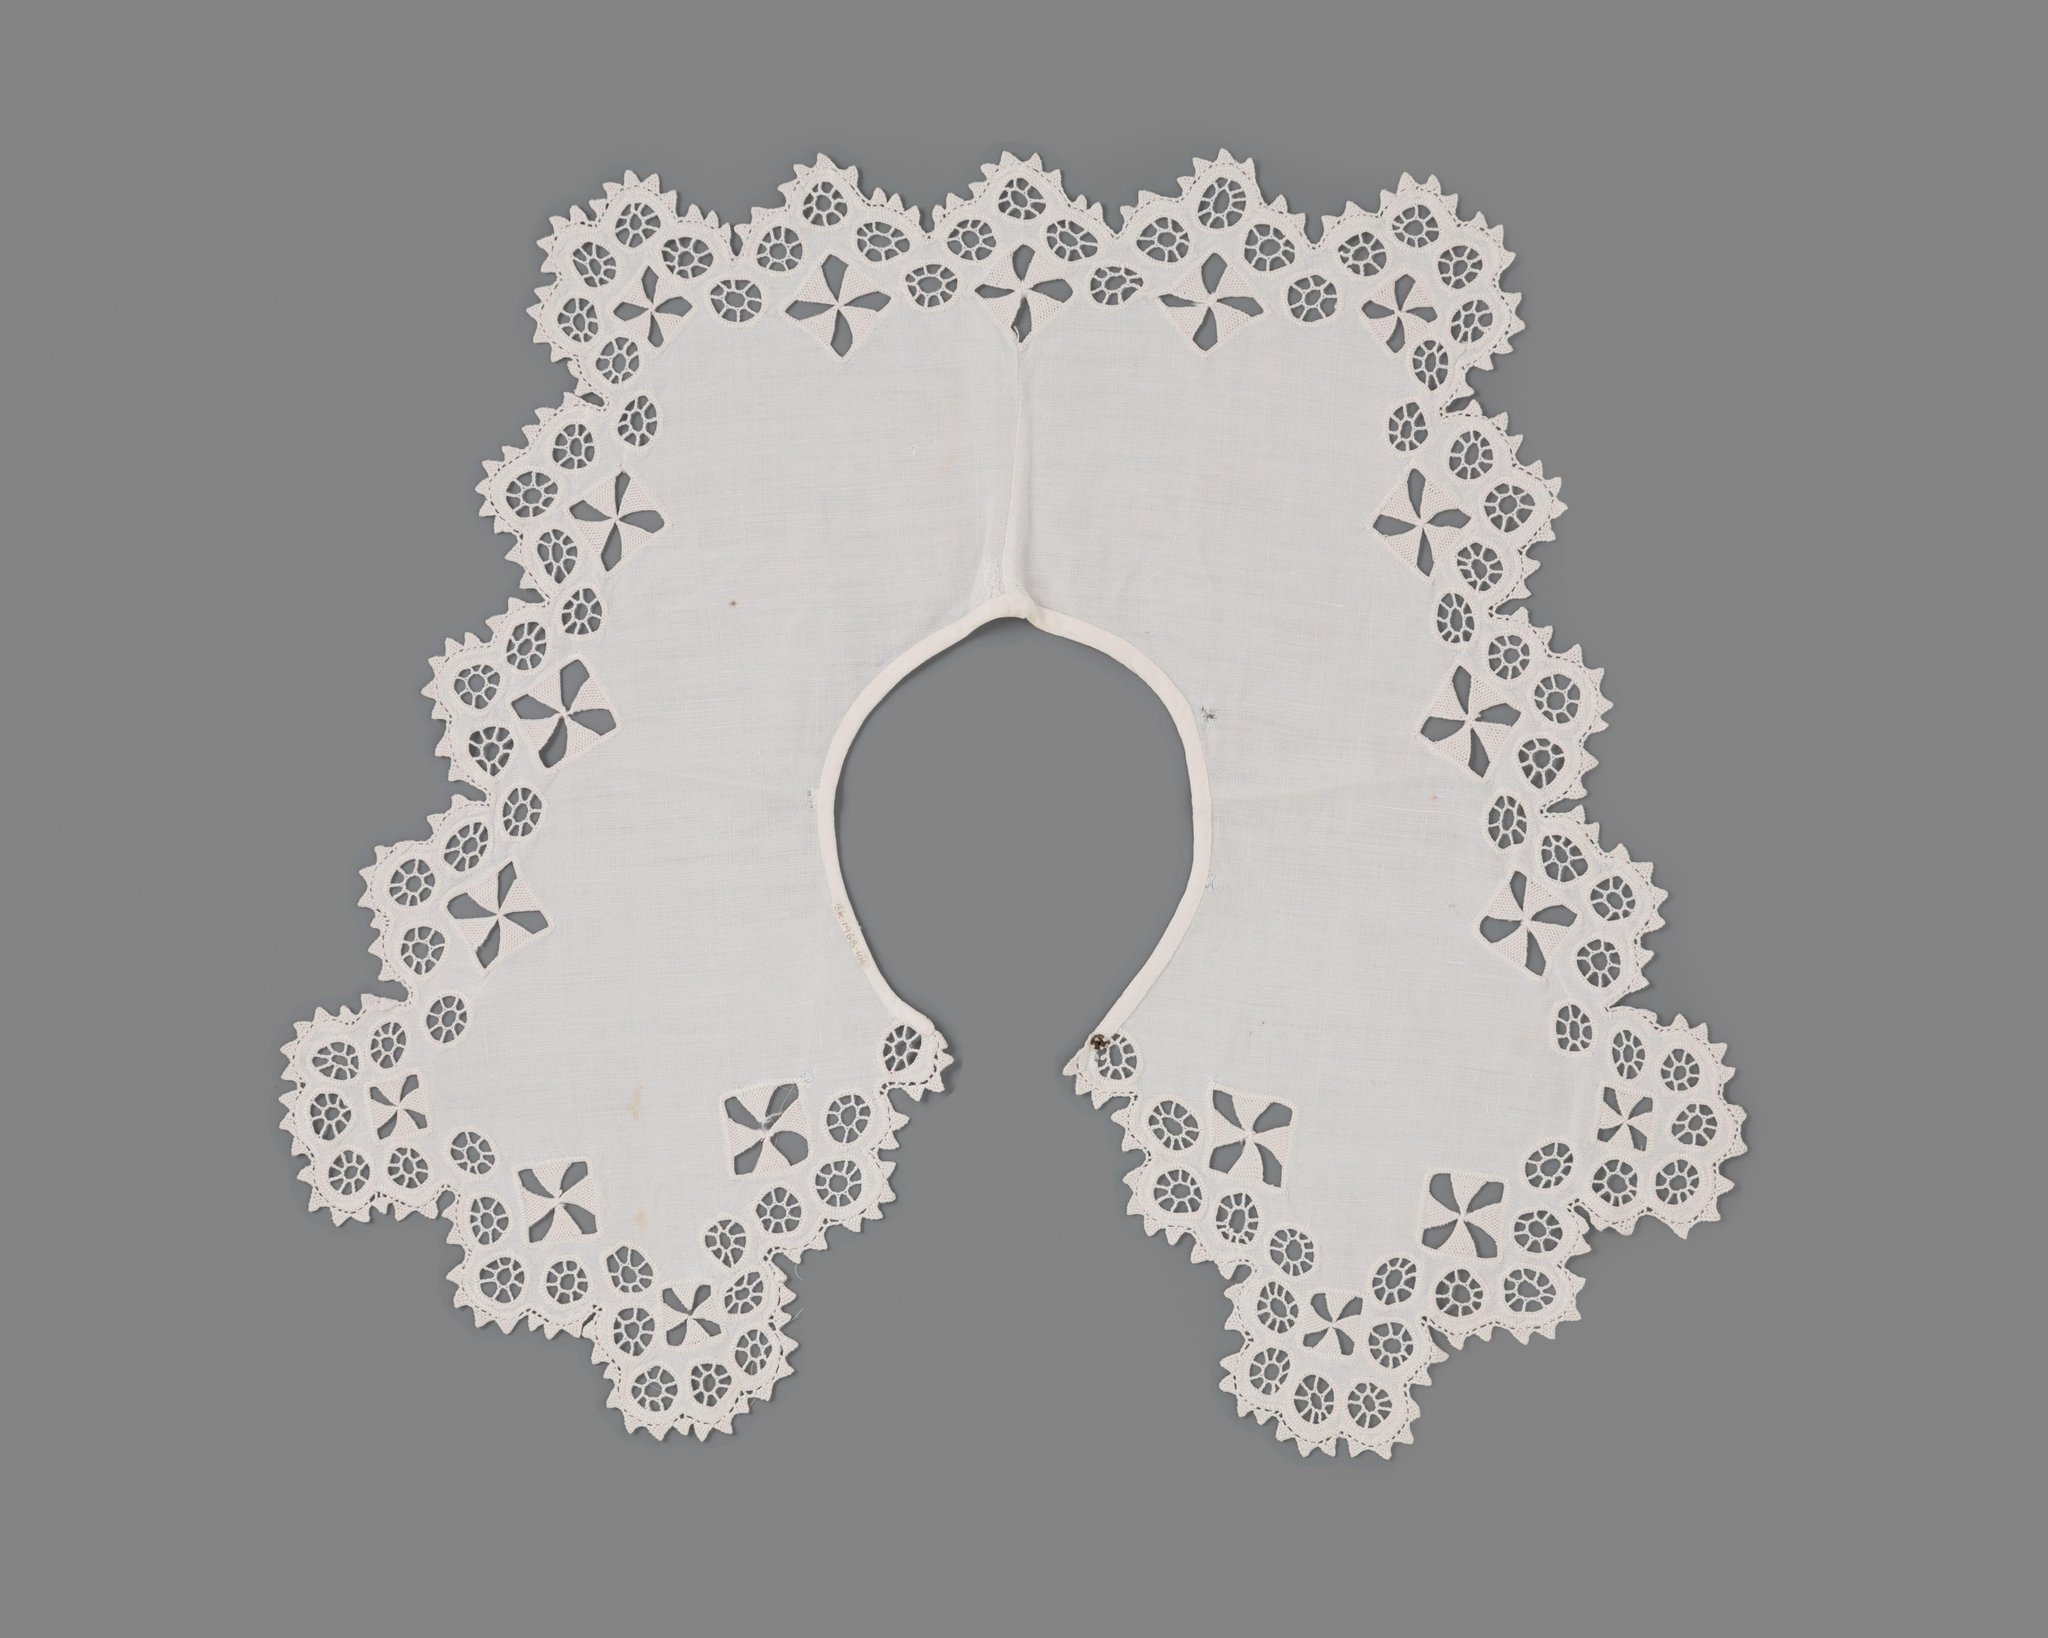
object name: collar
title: Kraag van wit linnen met open borduurwerk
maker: a.m.l.e. van assendelft de coningh-de roever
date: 1910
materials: linen, metal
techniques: embroidered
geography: netherlands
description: Kraag van linnen met open borduurwerk. Model: vierkant, liggend, met grote driehoekige punten. Borduurwerk. Rond, gefestonneerde en met spijltjes gebulde gaten lopen in eenaangesloten rij langs de punten. Hierachter één ruitvormige opening per schulp, elk gevuld met vier driehoekjes, opgebouwd van festonsteken.